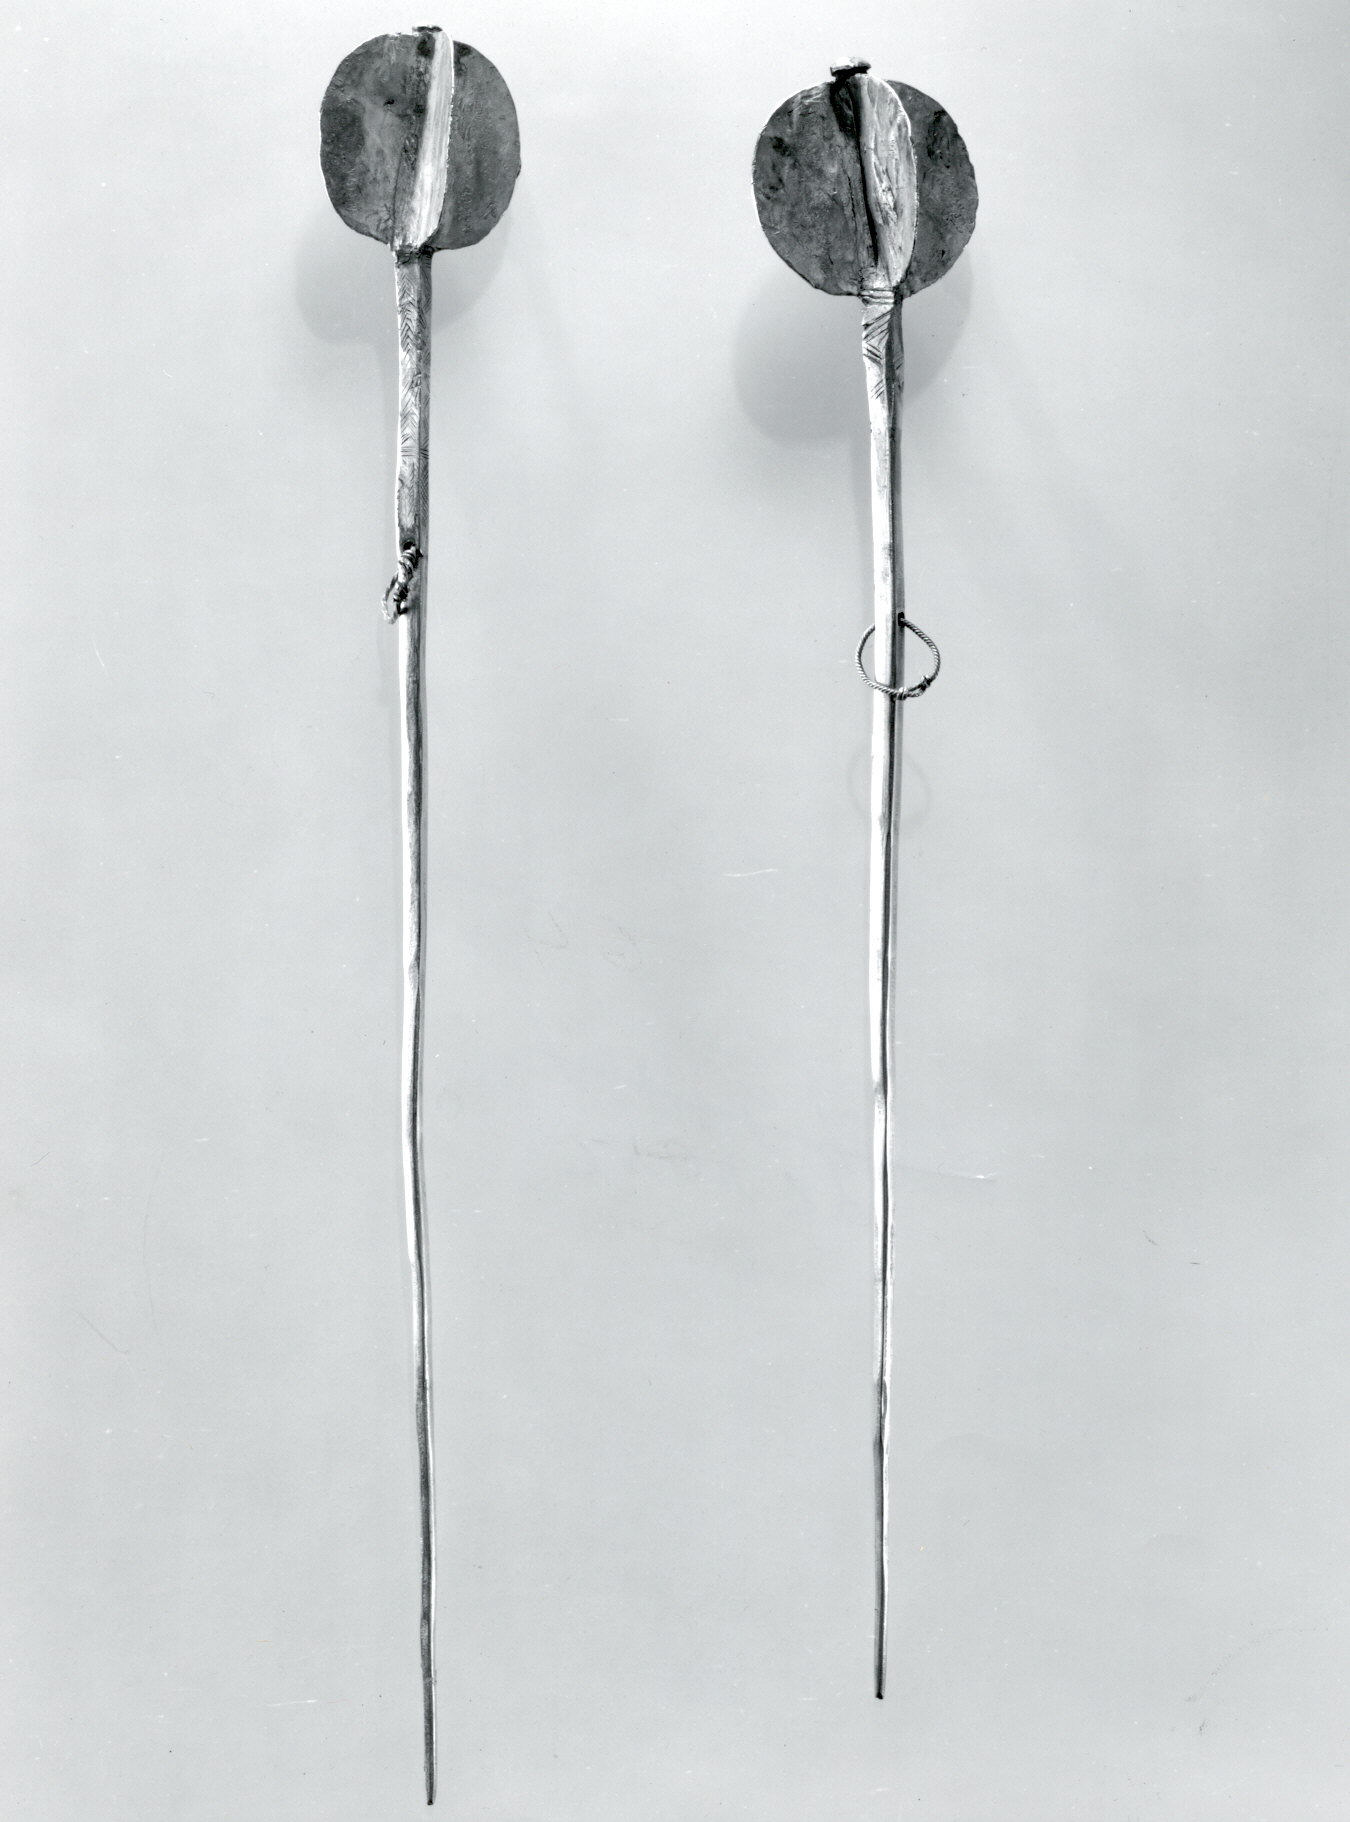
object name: pin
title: Pin with four flanges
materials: silver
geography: syria